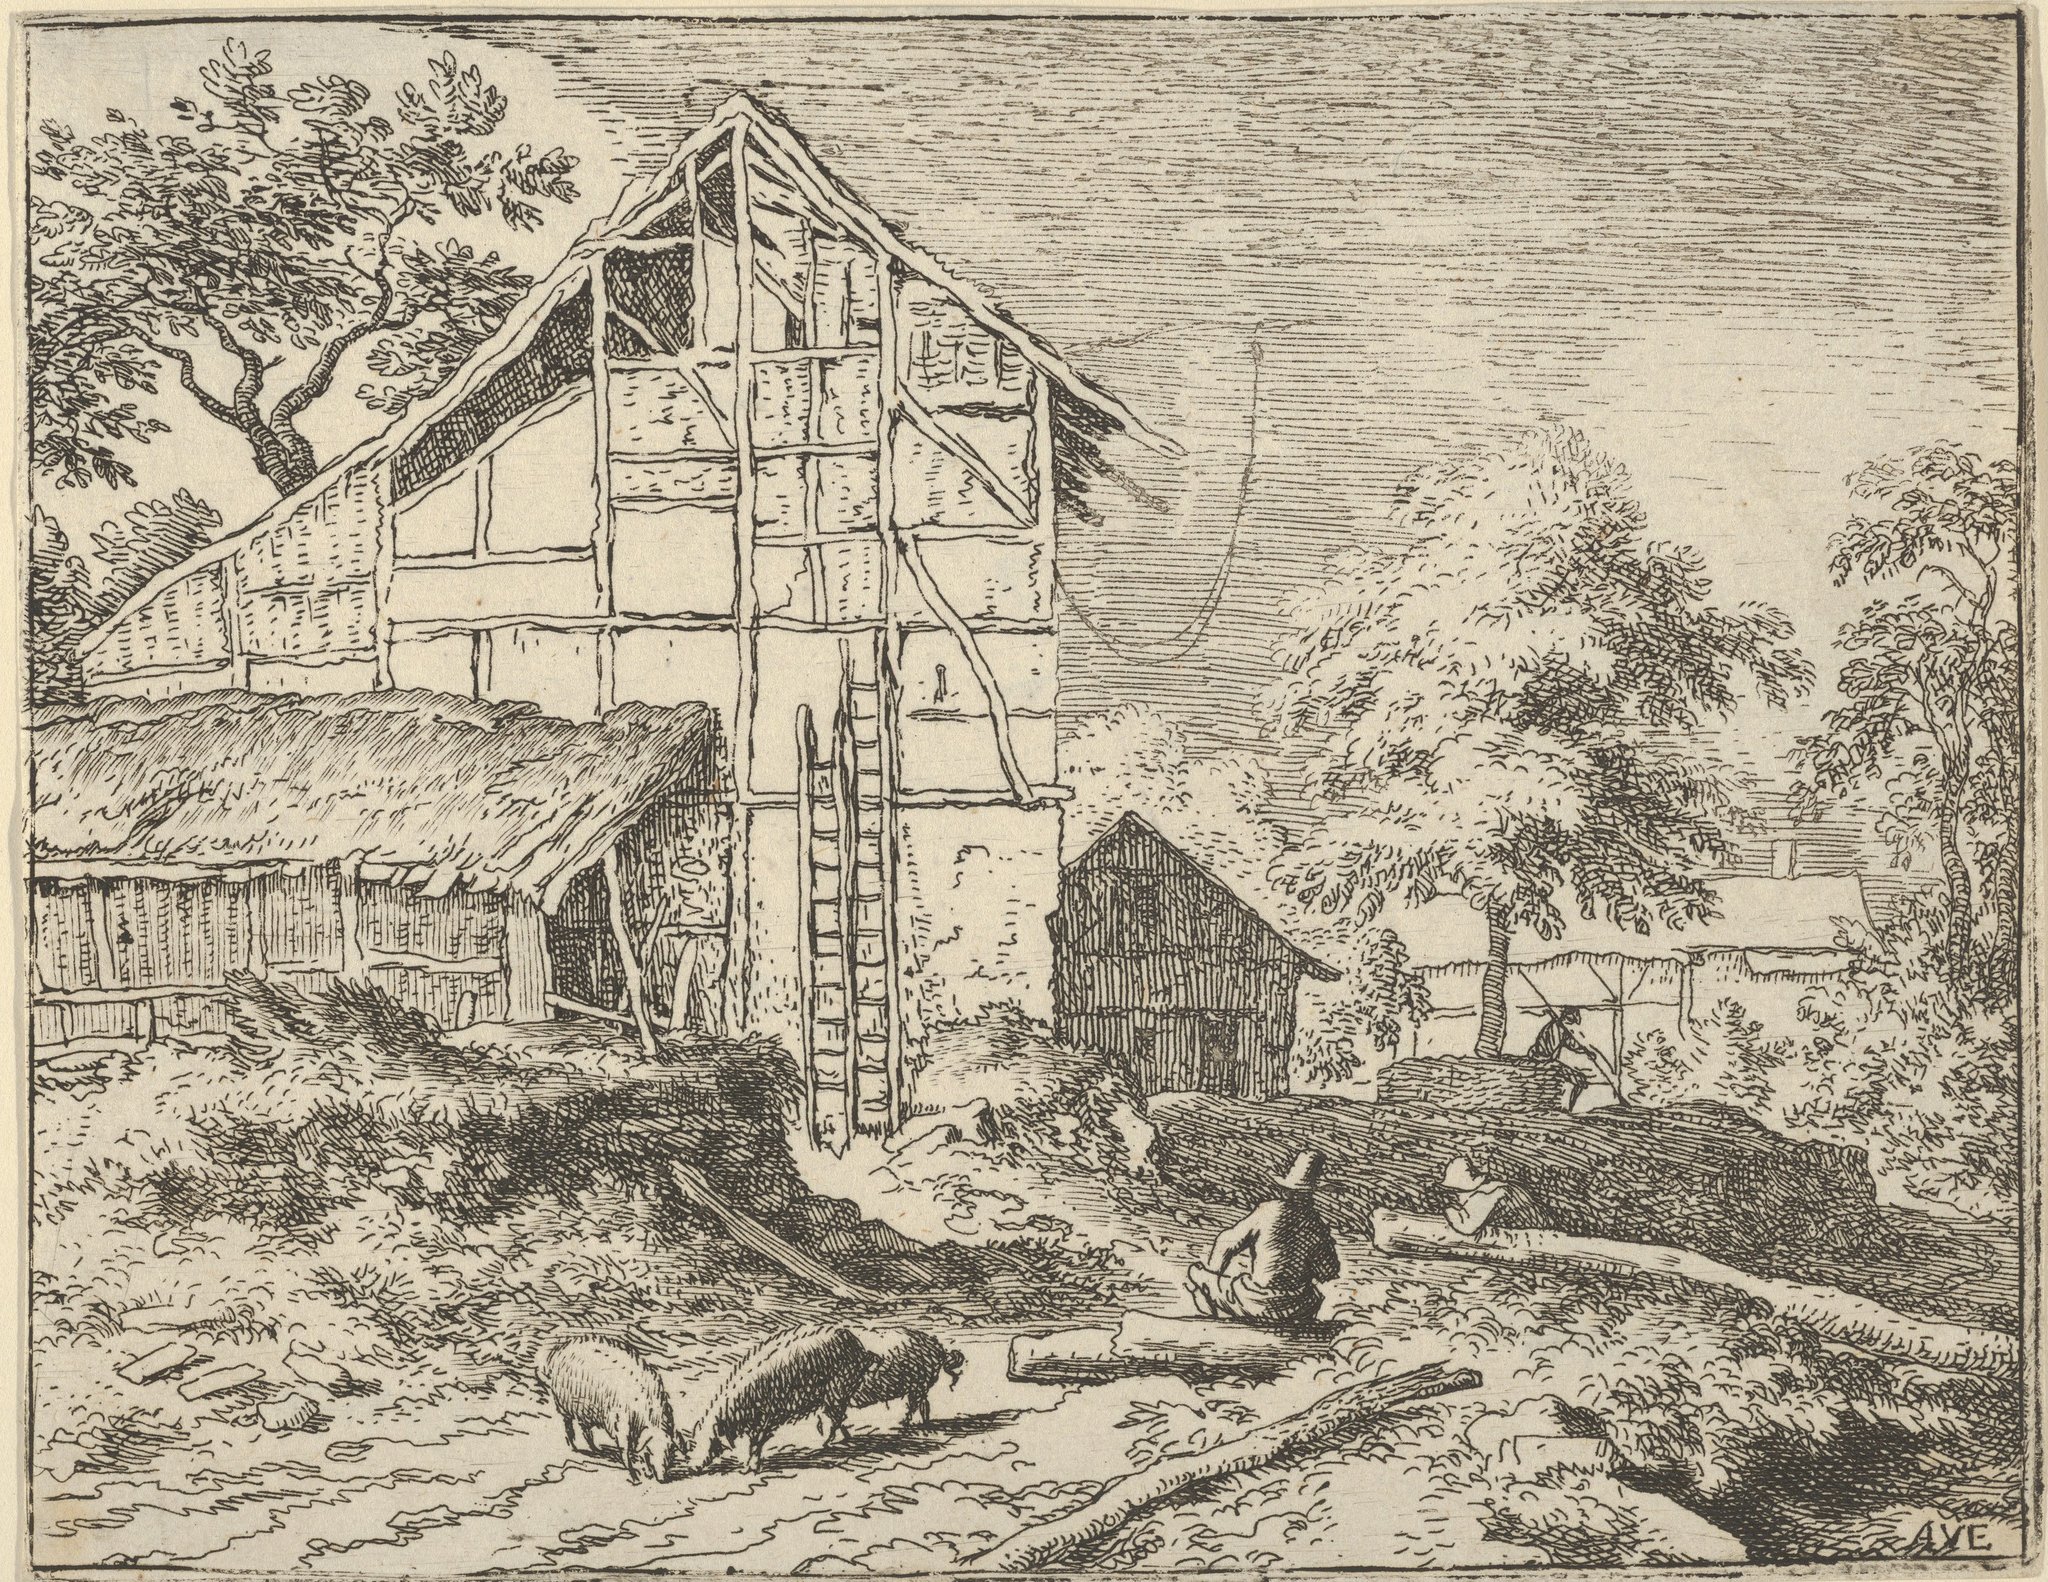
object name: print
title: The Two Ladders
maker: allart van everdingen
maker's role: artist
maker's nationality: dutch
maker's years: 1621-1675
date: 1621-1675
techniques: engraving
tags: animals,ladders